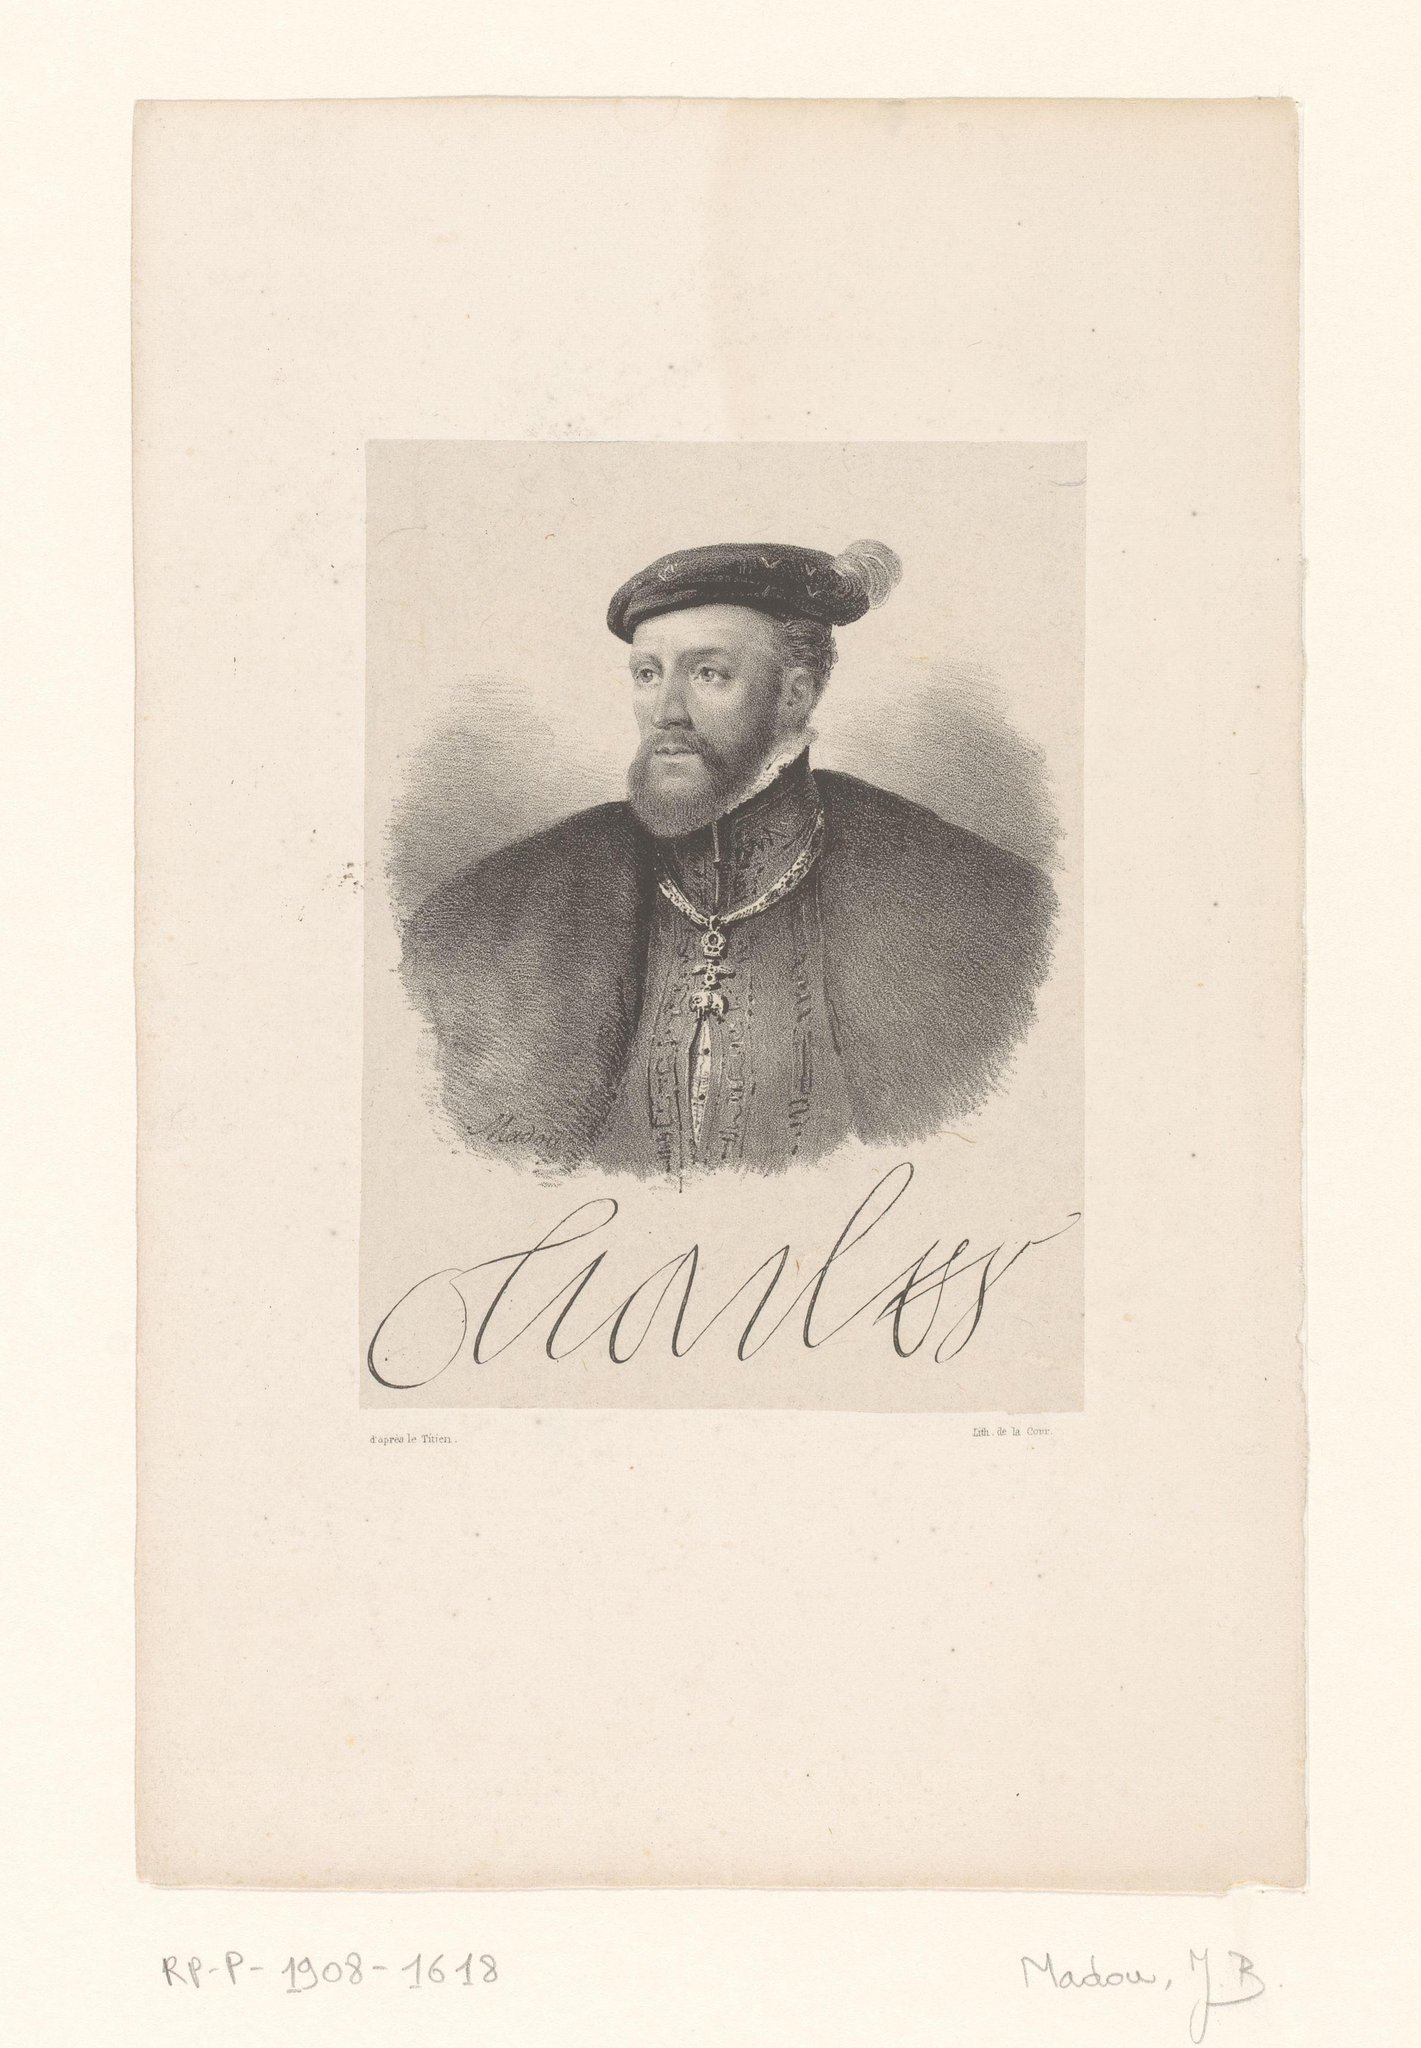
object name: print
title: Portret van keizer Karel V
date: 1827-1851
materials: paper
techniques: lithograph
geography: brussels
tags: charles v (holy roman emperor and king of spain), adult man, historical persons, beard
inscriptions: collector's mark: Lugt 2228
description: Onder het portret naam in sierschrift: Karlus.